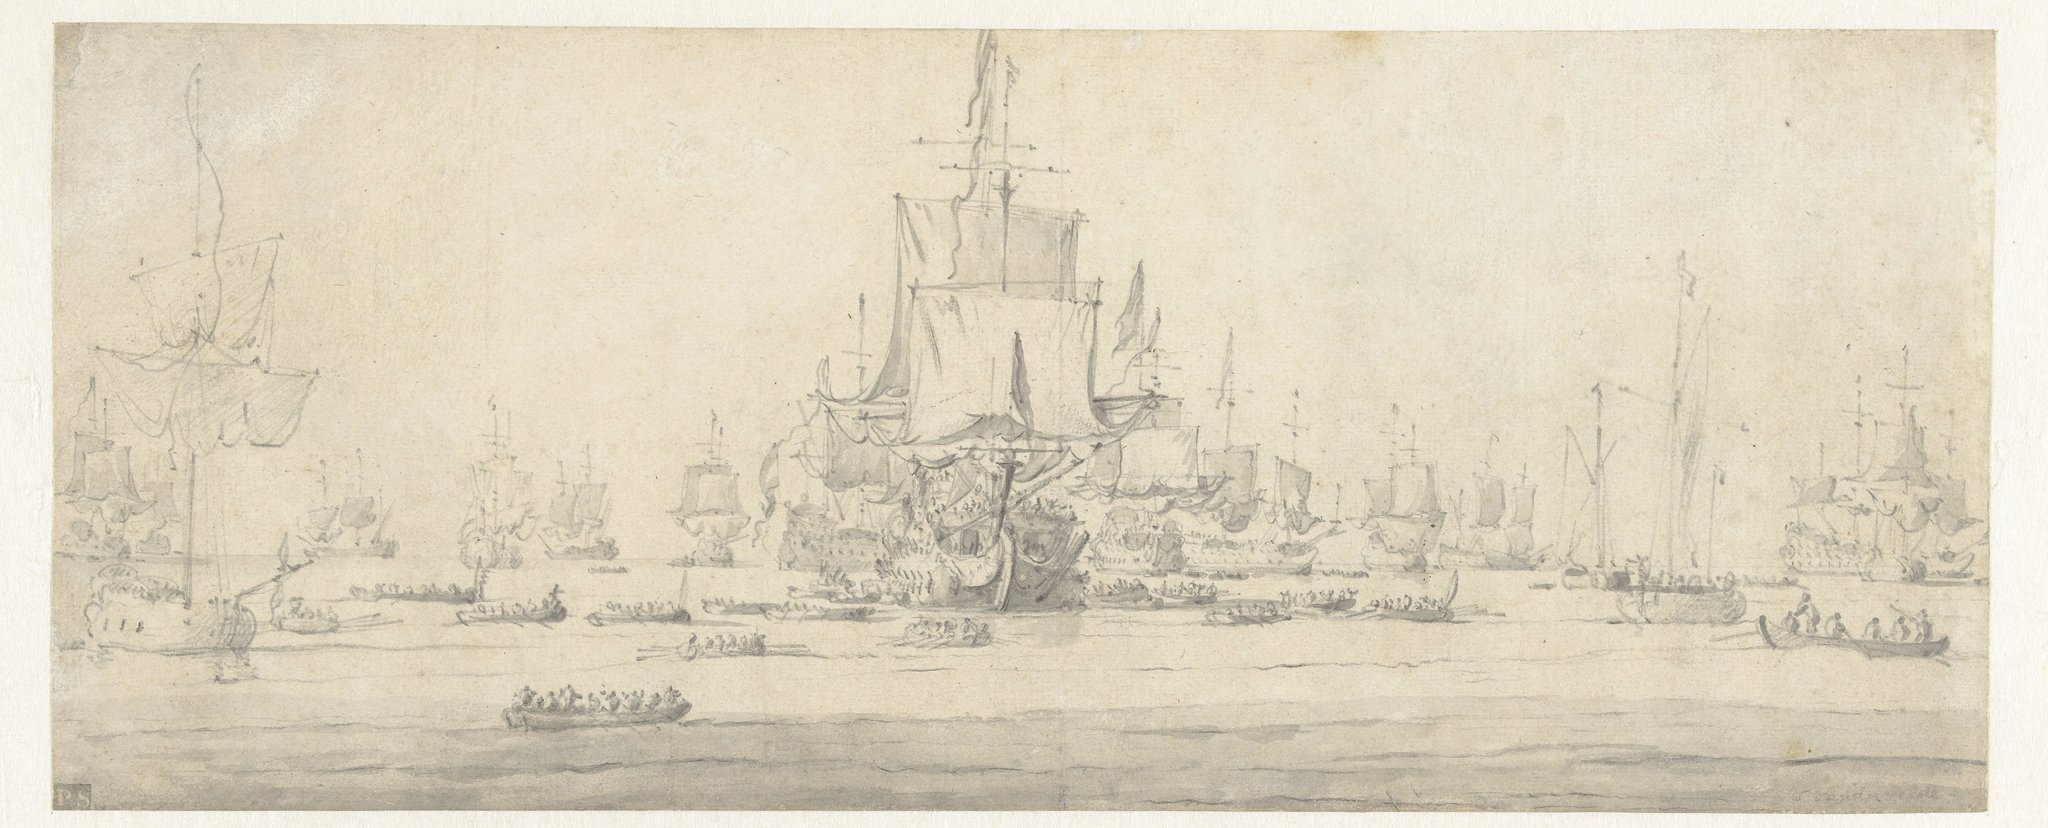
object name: drawing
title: Krijgsraad van de Nederlandse vloot voor de Vierdaagse Zeeslag in 1666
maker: willem van de velde (ii)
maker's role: draughtsman, painter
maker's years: 1633-1707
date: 1666-1671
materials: paper, pencil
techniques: brush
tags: sailing-ship, sailing-boat, council of war, battle (+ sailing-ships), navy (+ sailing-ships), historical events and situations